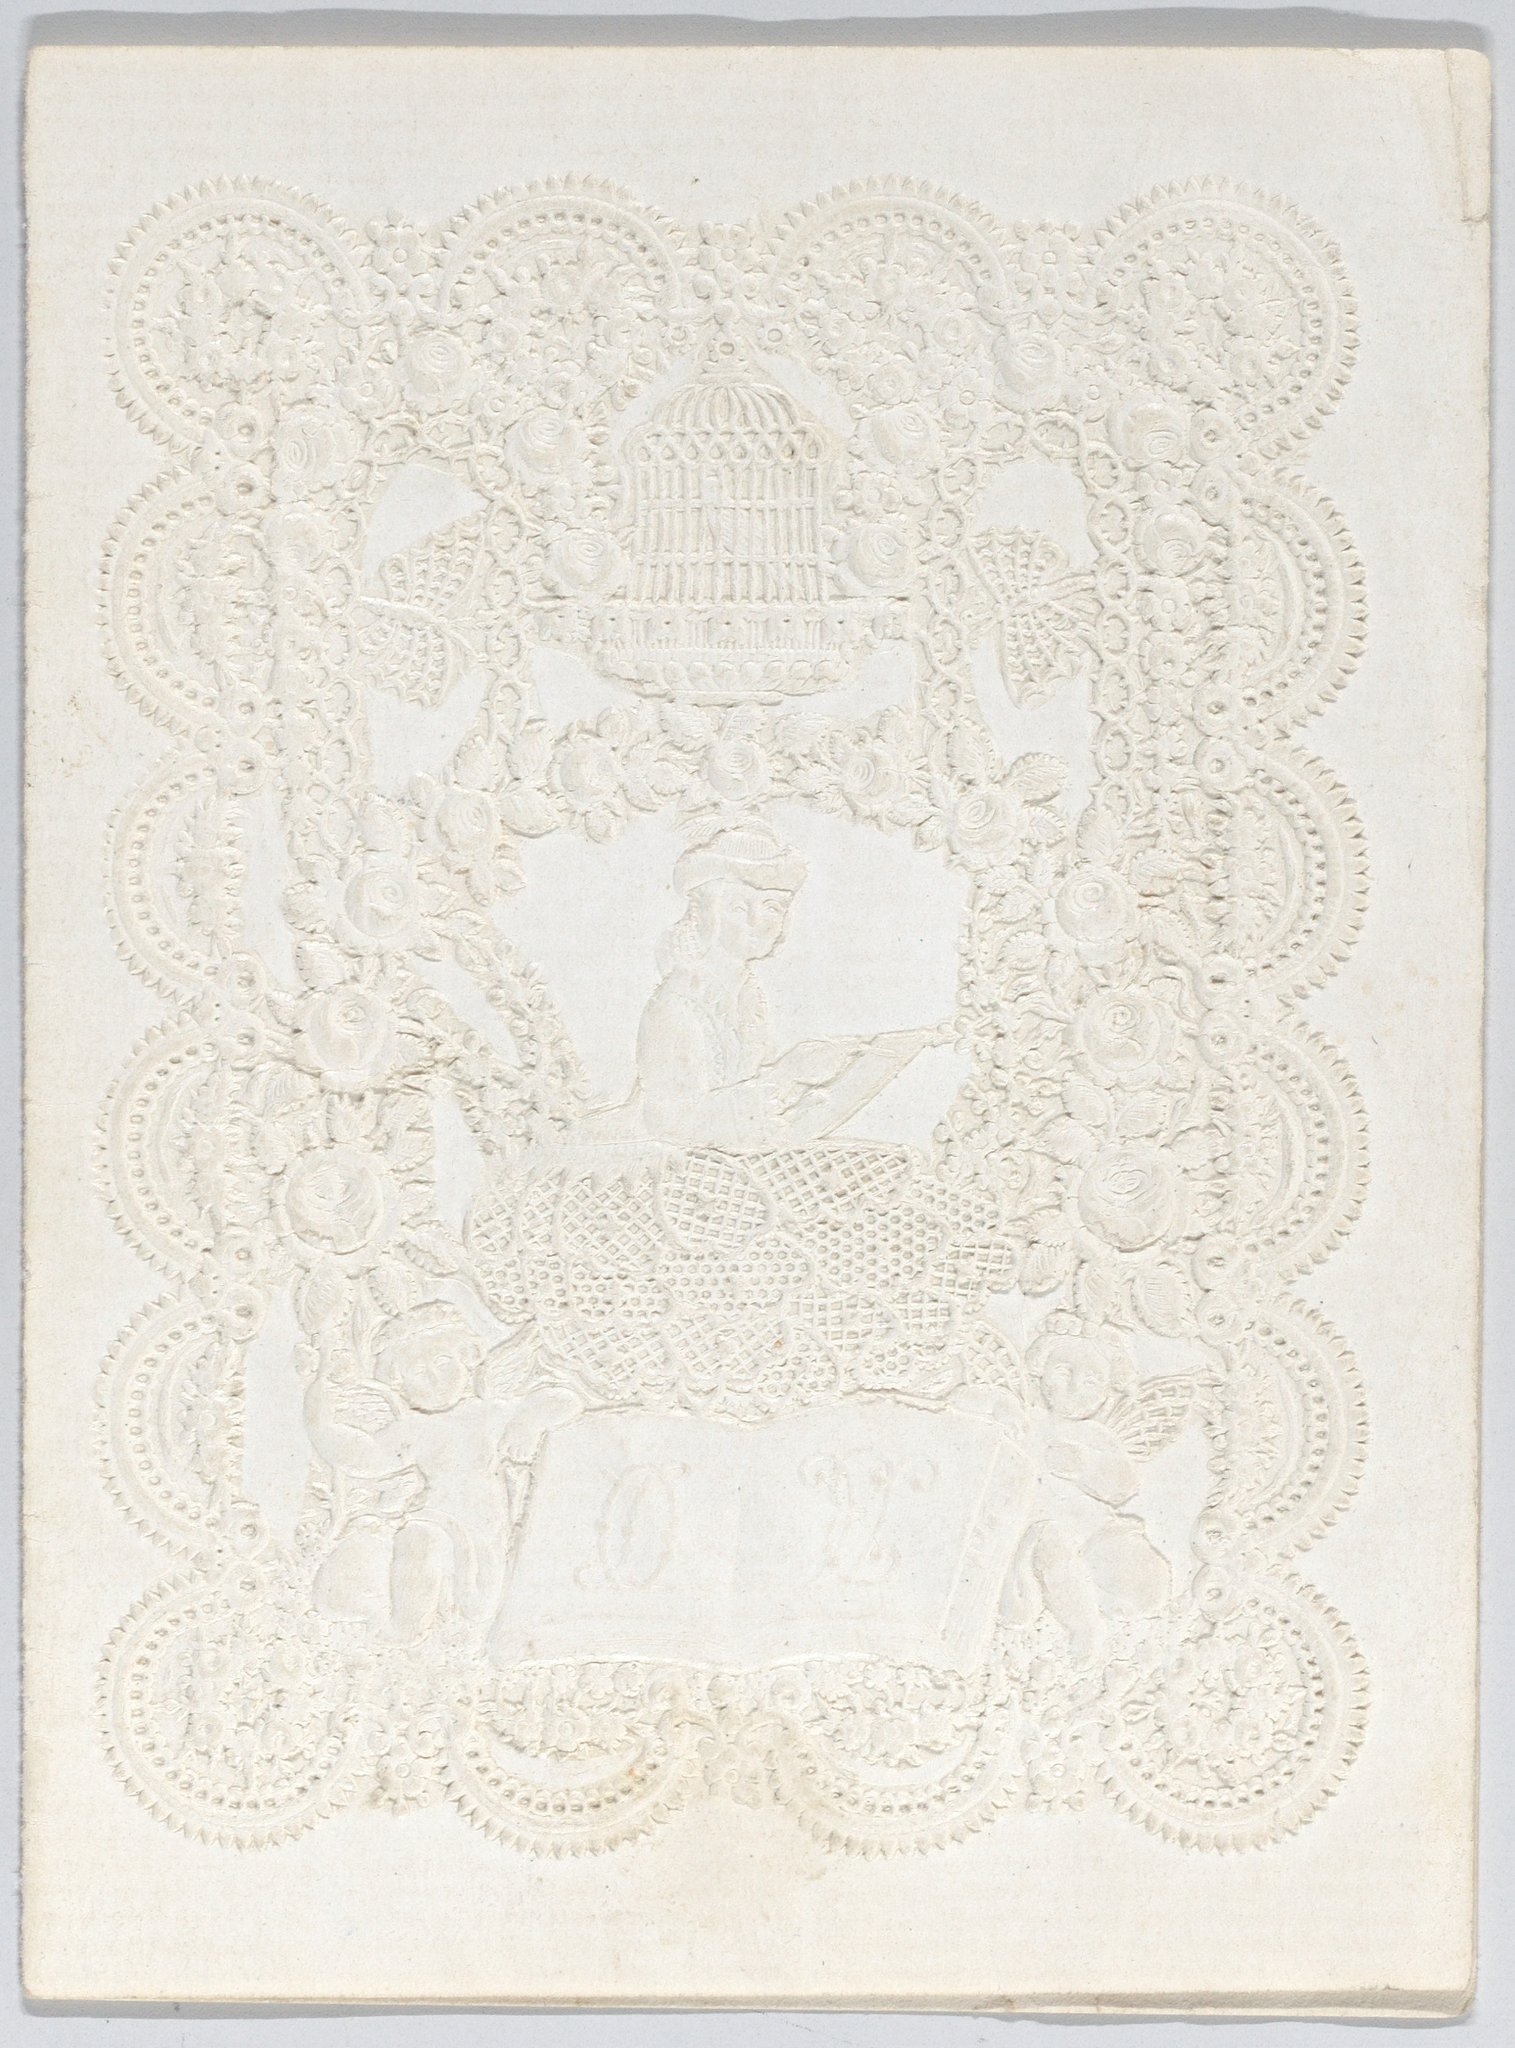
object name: valentine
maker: Anonymous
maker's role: artist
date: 1847-1870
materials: paper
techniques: embossing